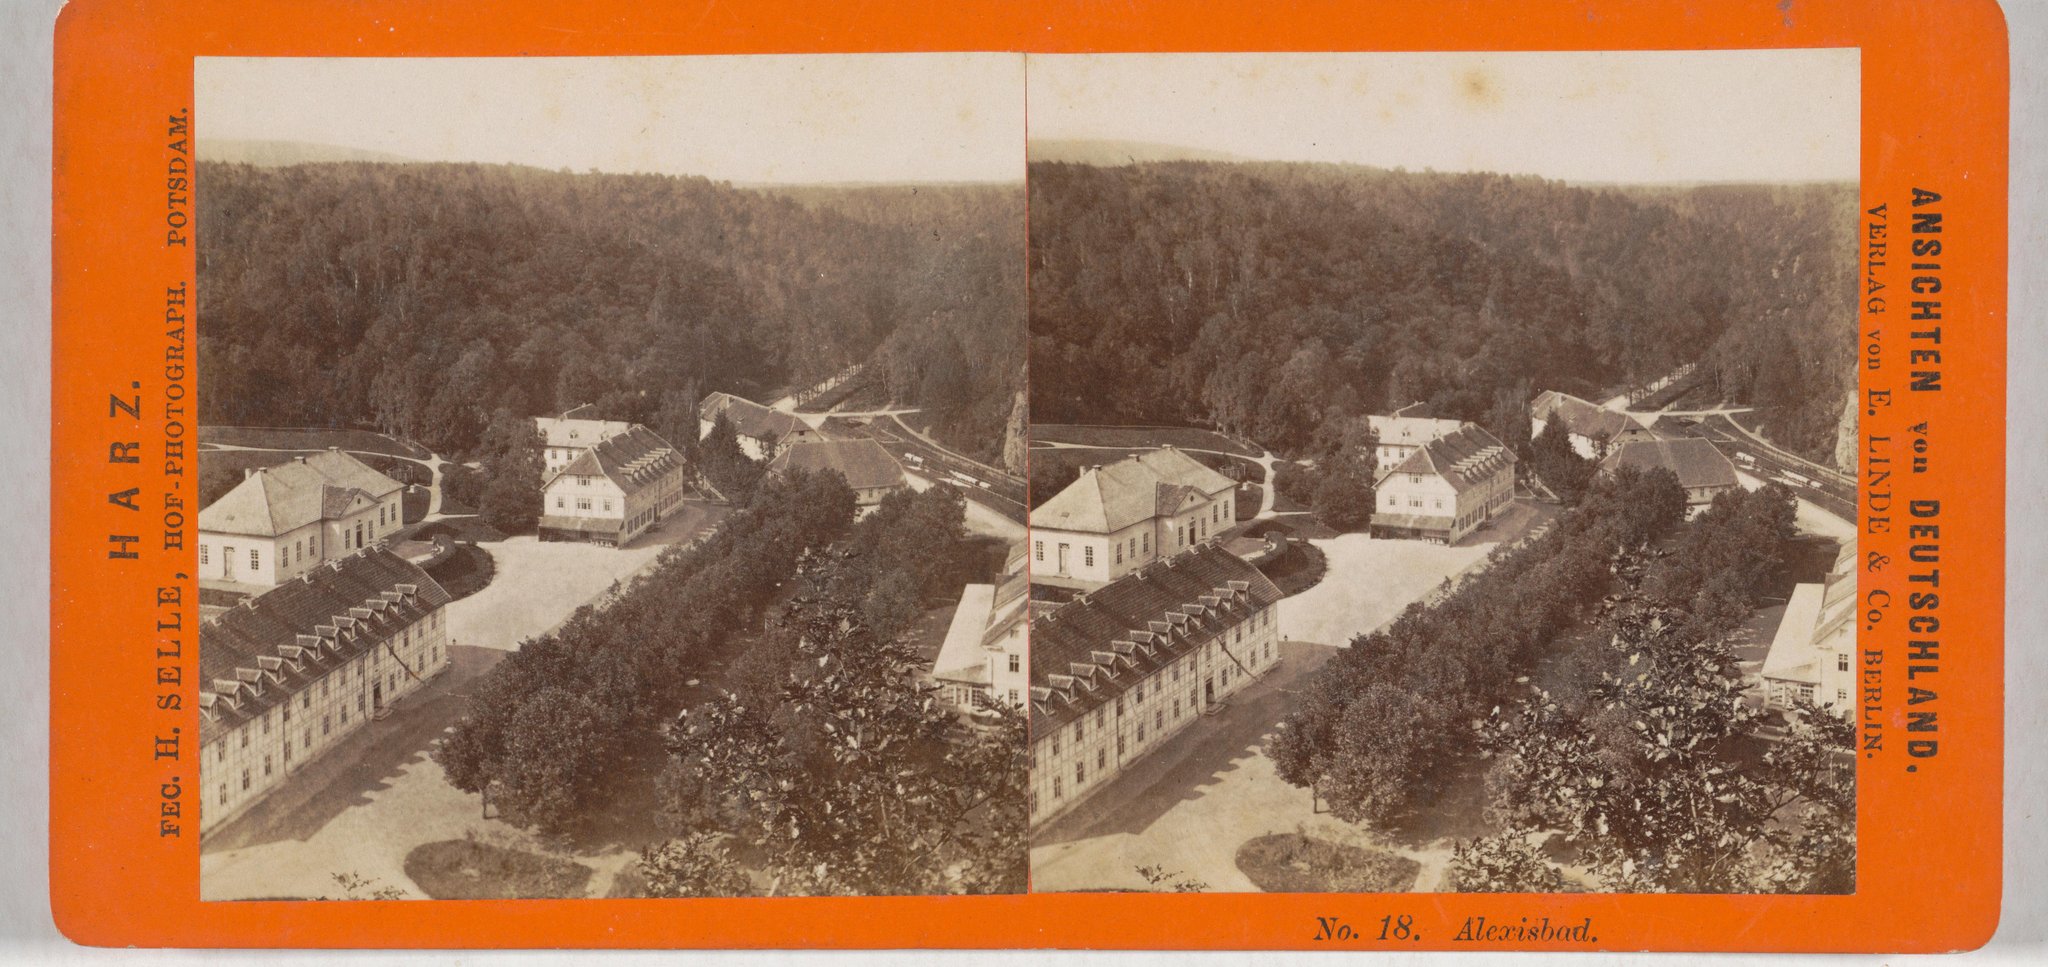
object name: stereograph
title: Gezicht op Alexisbad in de Harz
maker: hermann selle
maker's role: fotograaf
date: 1868-1890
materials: cardboard, paper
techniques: albumen print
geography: berlin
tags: village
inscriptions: inscription: ‘Hof-Photograph. Potsdam.’, inscription: ‘No. 18. Harz. Alexisbad/ im Selkethale./ In einer bedeutenderen Ausweitung (...) aus nicht fern. (W.Riehl.)’, number: ‘No. 18.’